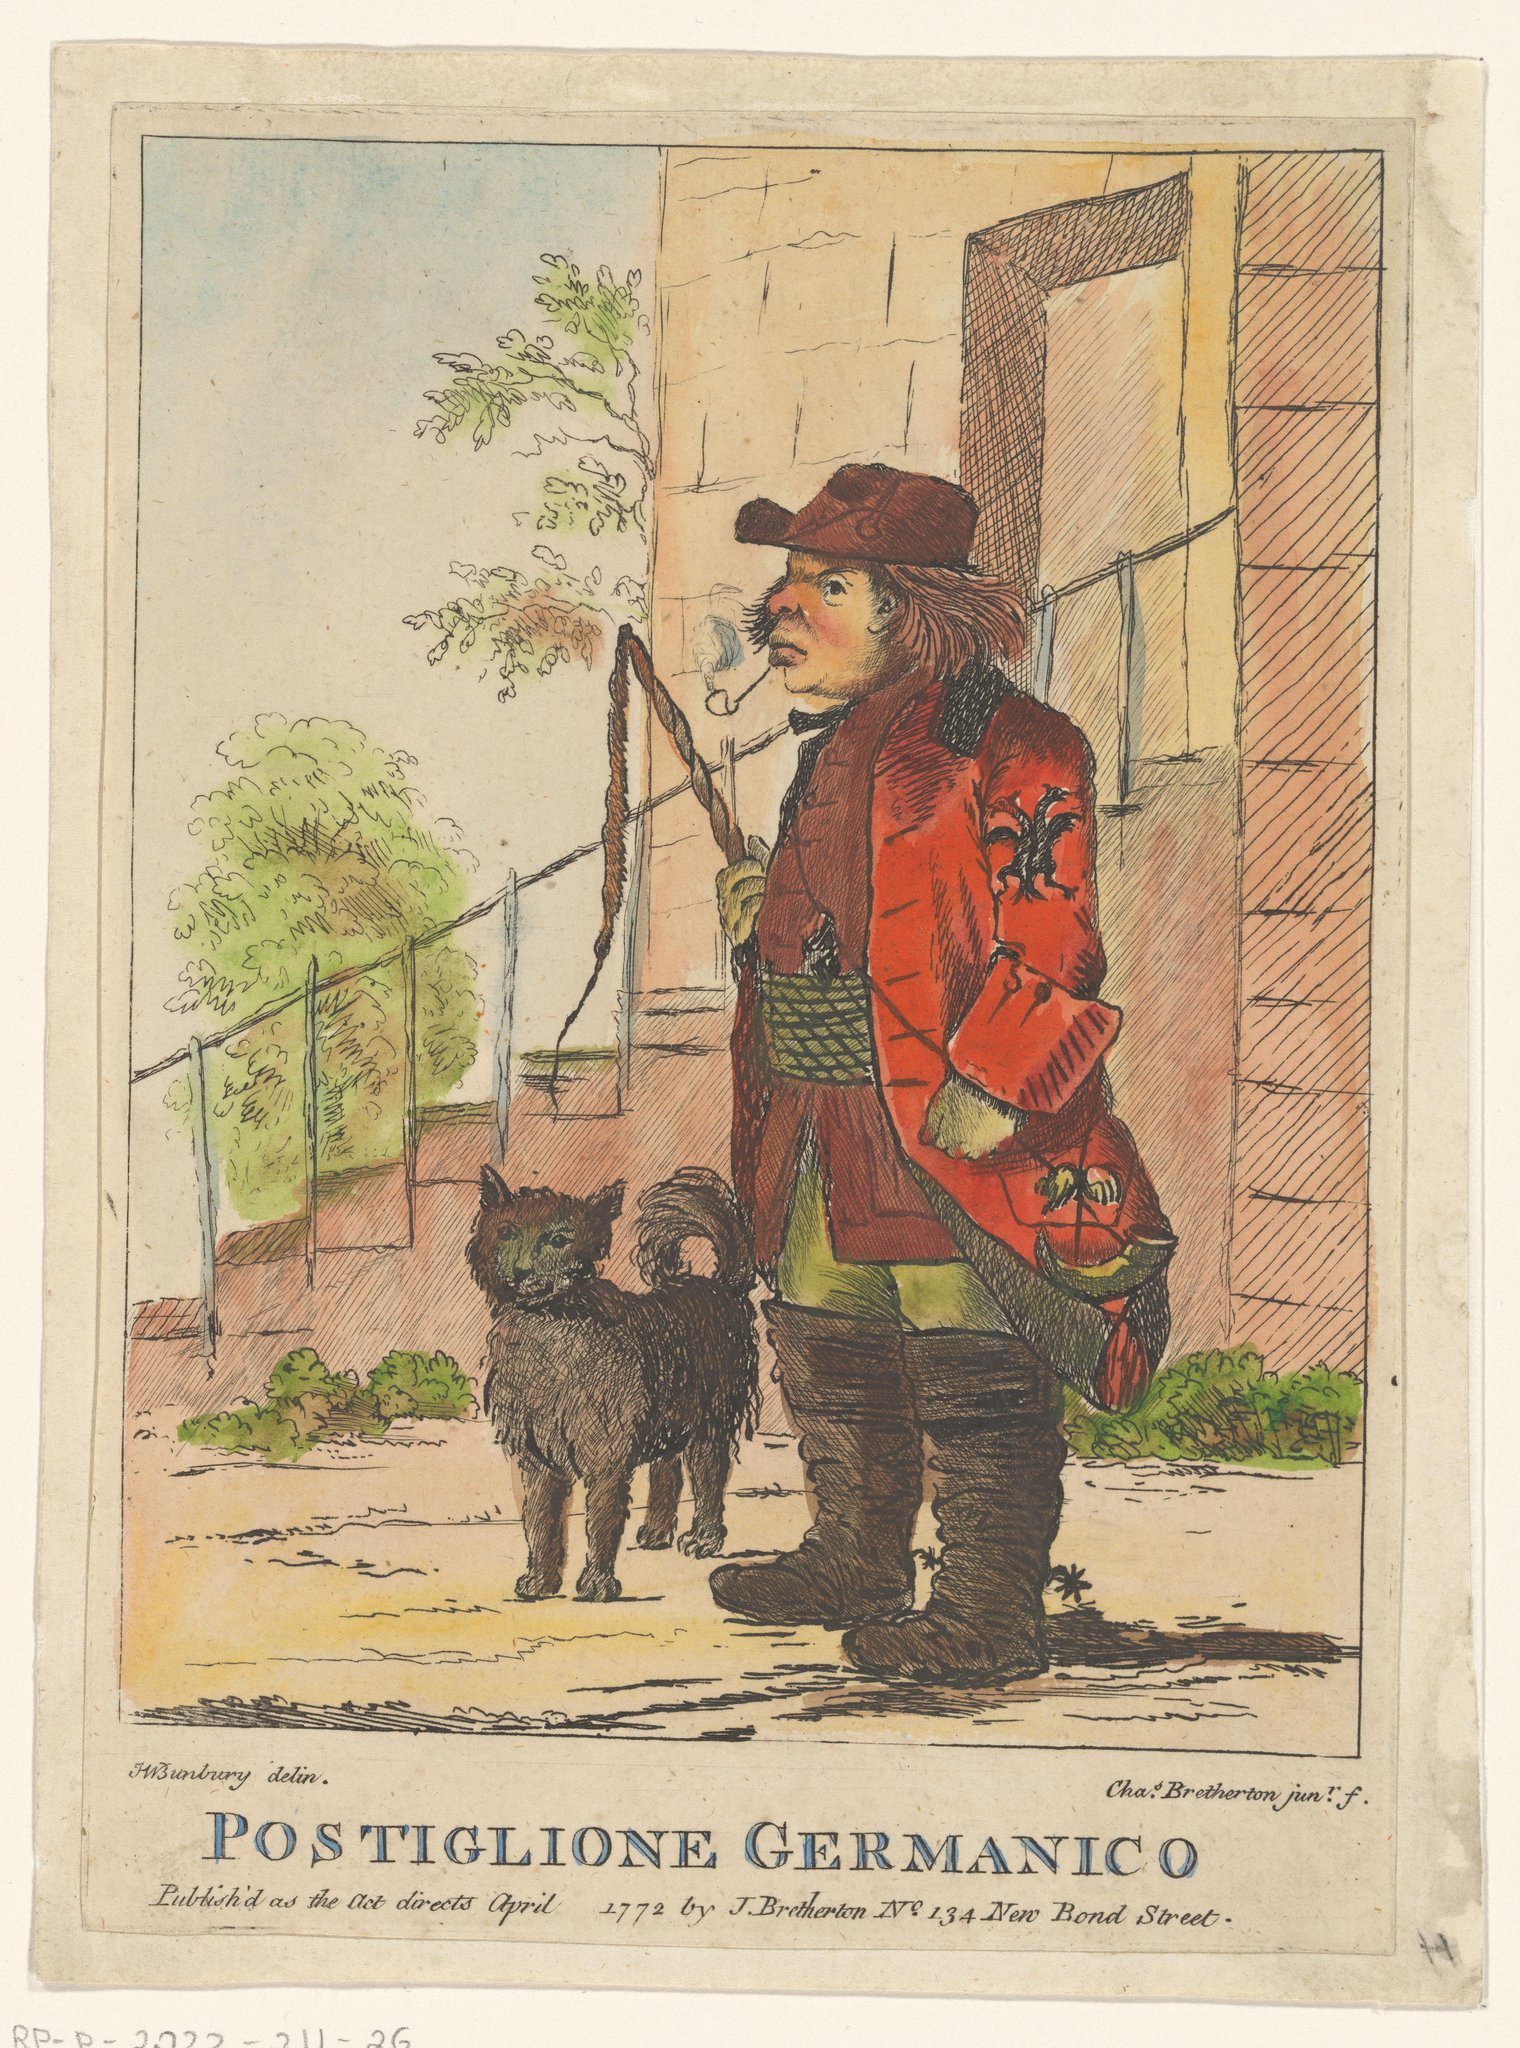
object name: cartoon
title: Postiglione Germanico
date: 1772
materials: paper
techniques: etching, hand coloring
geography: london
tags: caricatures (human types), europeans: germans (+ caricatured), dog, whip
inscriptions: collector's mark: Lugt 2228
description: Satire op postiljons. Een Duitse postiljon staat een pijp te roken. Hij draagt een jas met een dubbelkoppige adelaar op de mouw. Verder draagt hij een hoorn aan een koord aan zijn zijde en heeft hij een zweep in zijn rechterhand. Hij staat voor een trap met een hond aan zijn zijde.